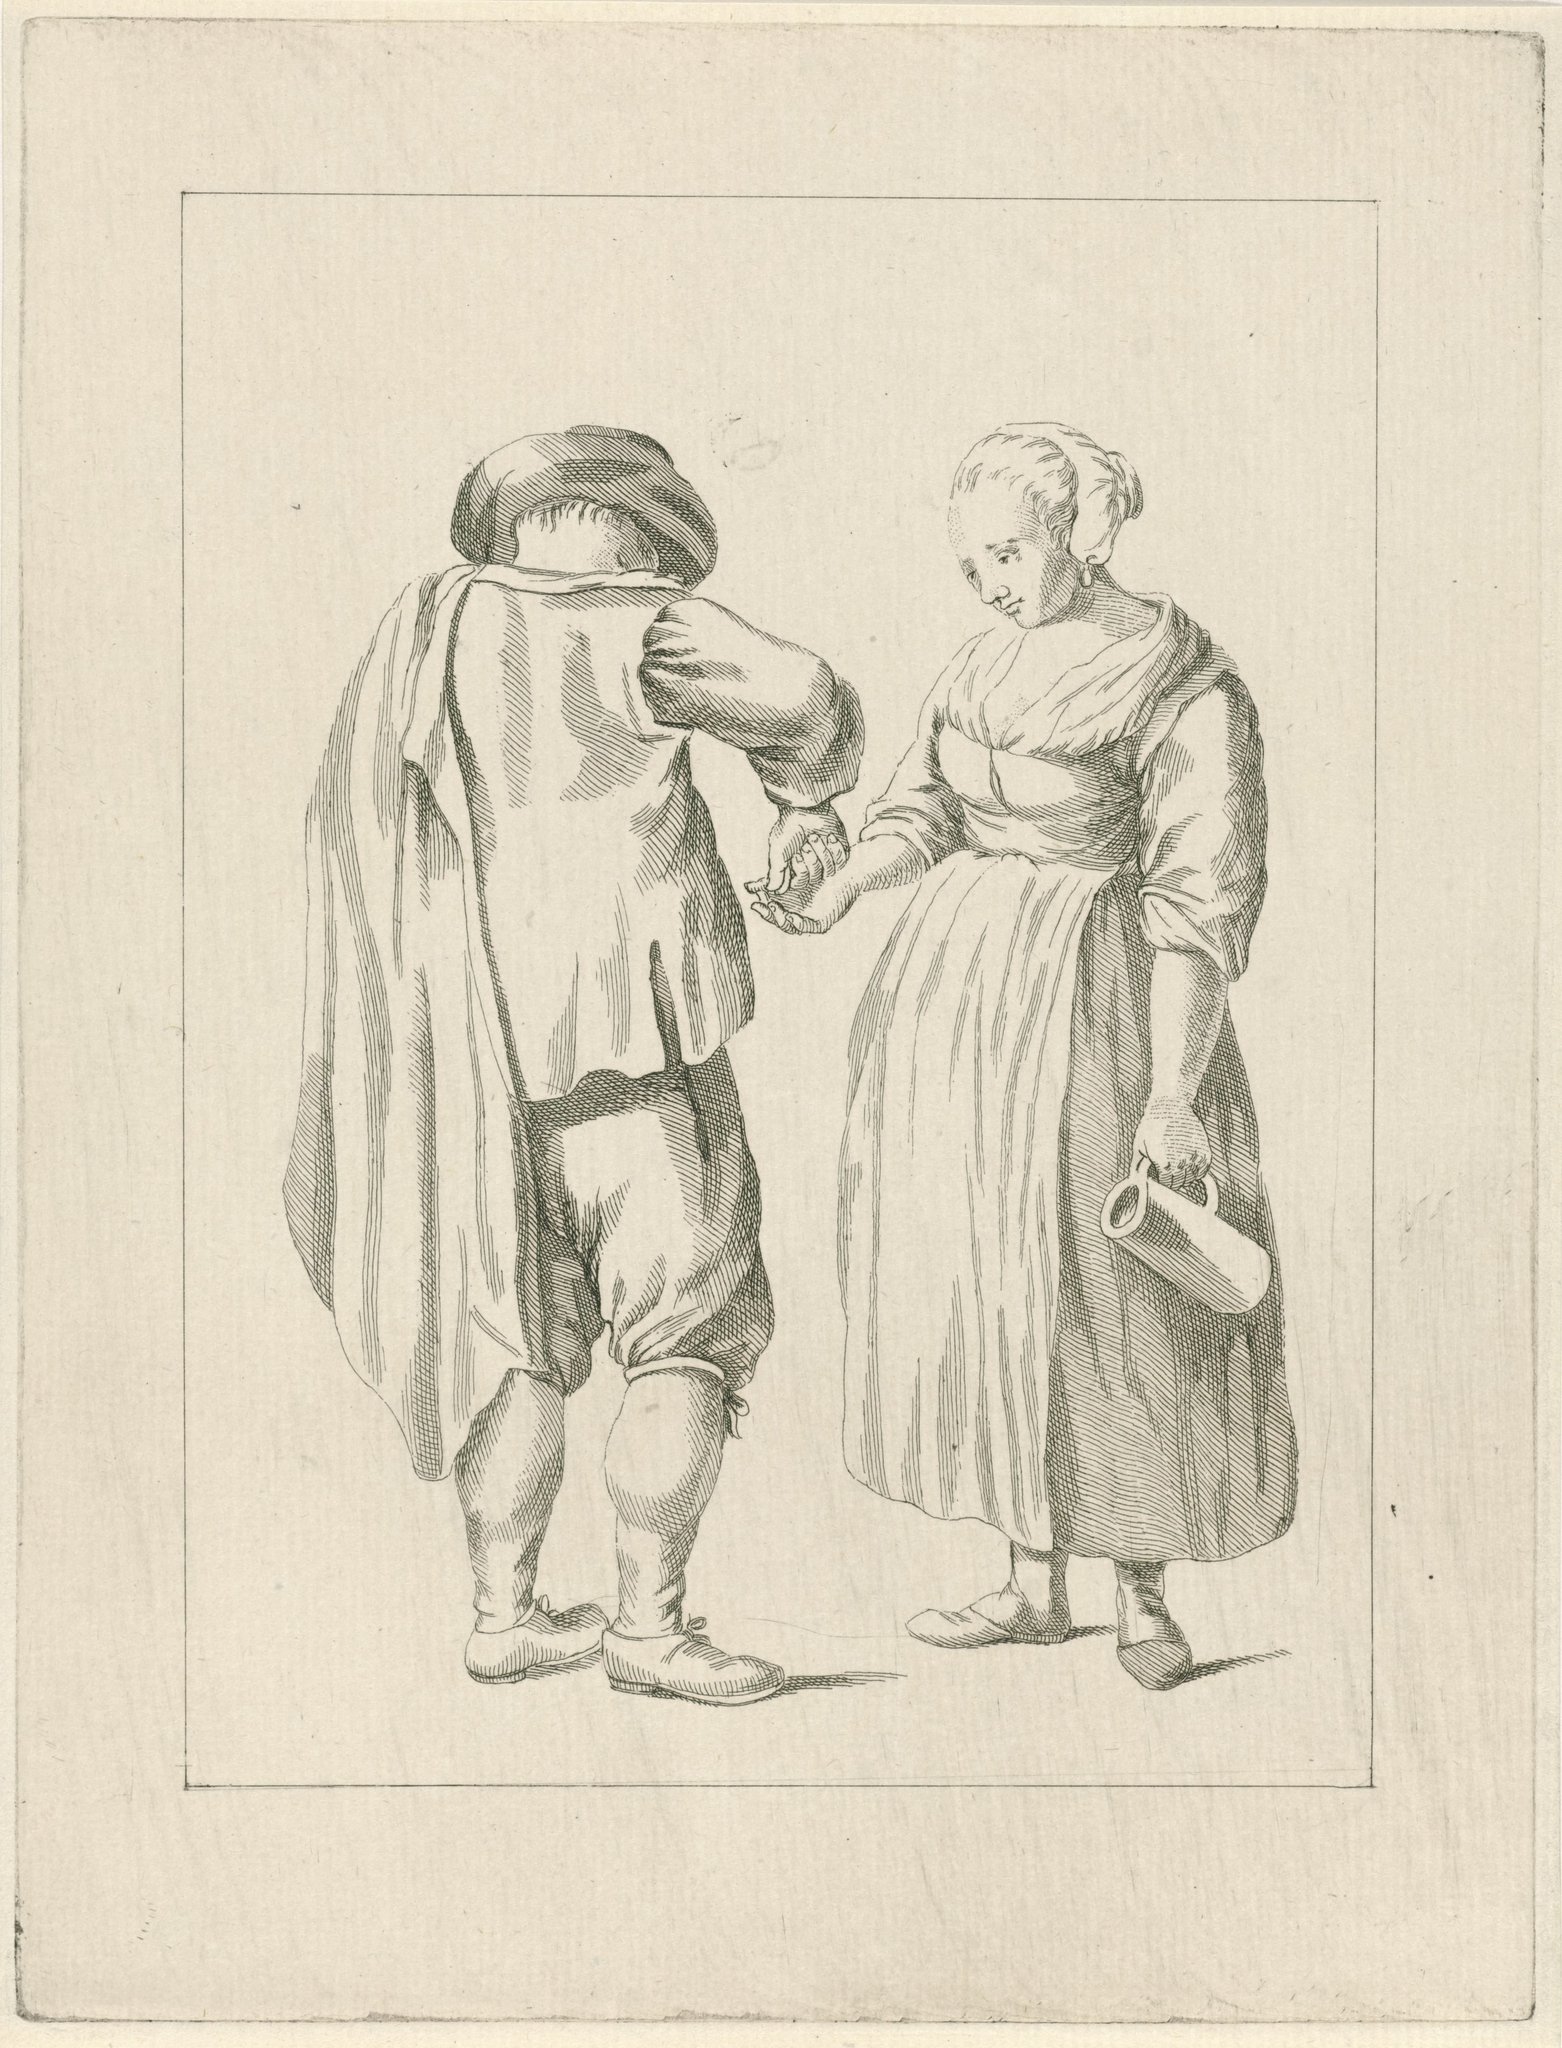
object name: print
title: Man betaalt vrouw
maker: pieter de mare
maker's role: print maker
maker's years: 1758-1796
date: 1768-1796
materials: paper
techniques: etching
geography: leiden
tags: paying (~ commerce) (here also repayment of debt, etc.), coin, container of ceramics: jar, jug, pot, vase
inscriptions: collector's mark: Lugt 240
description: Een man op de rug gezien betaalt een vrouw munten in haar hand, in haar andere hand heeft zij een kruik.